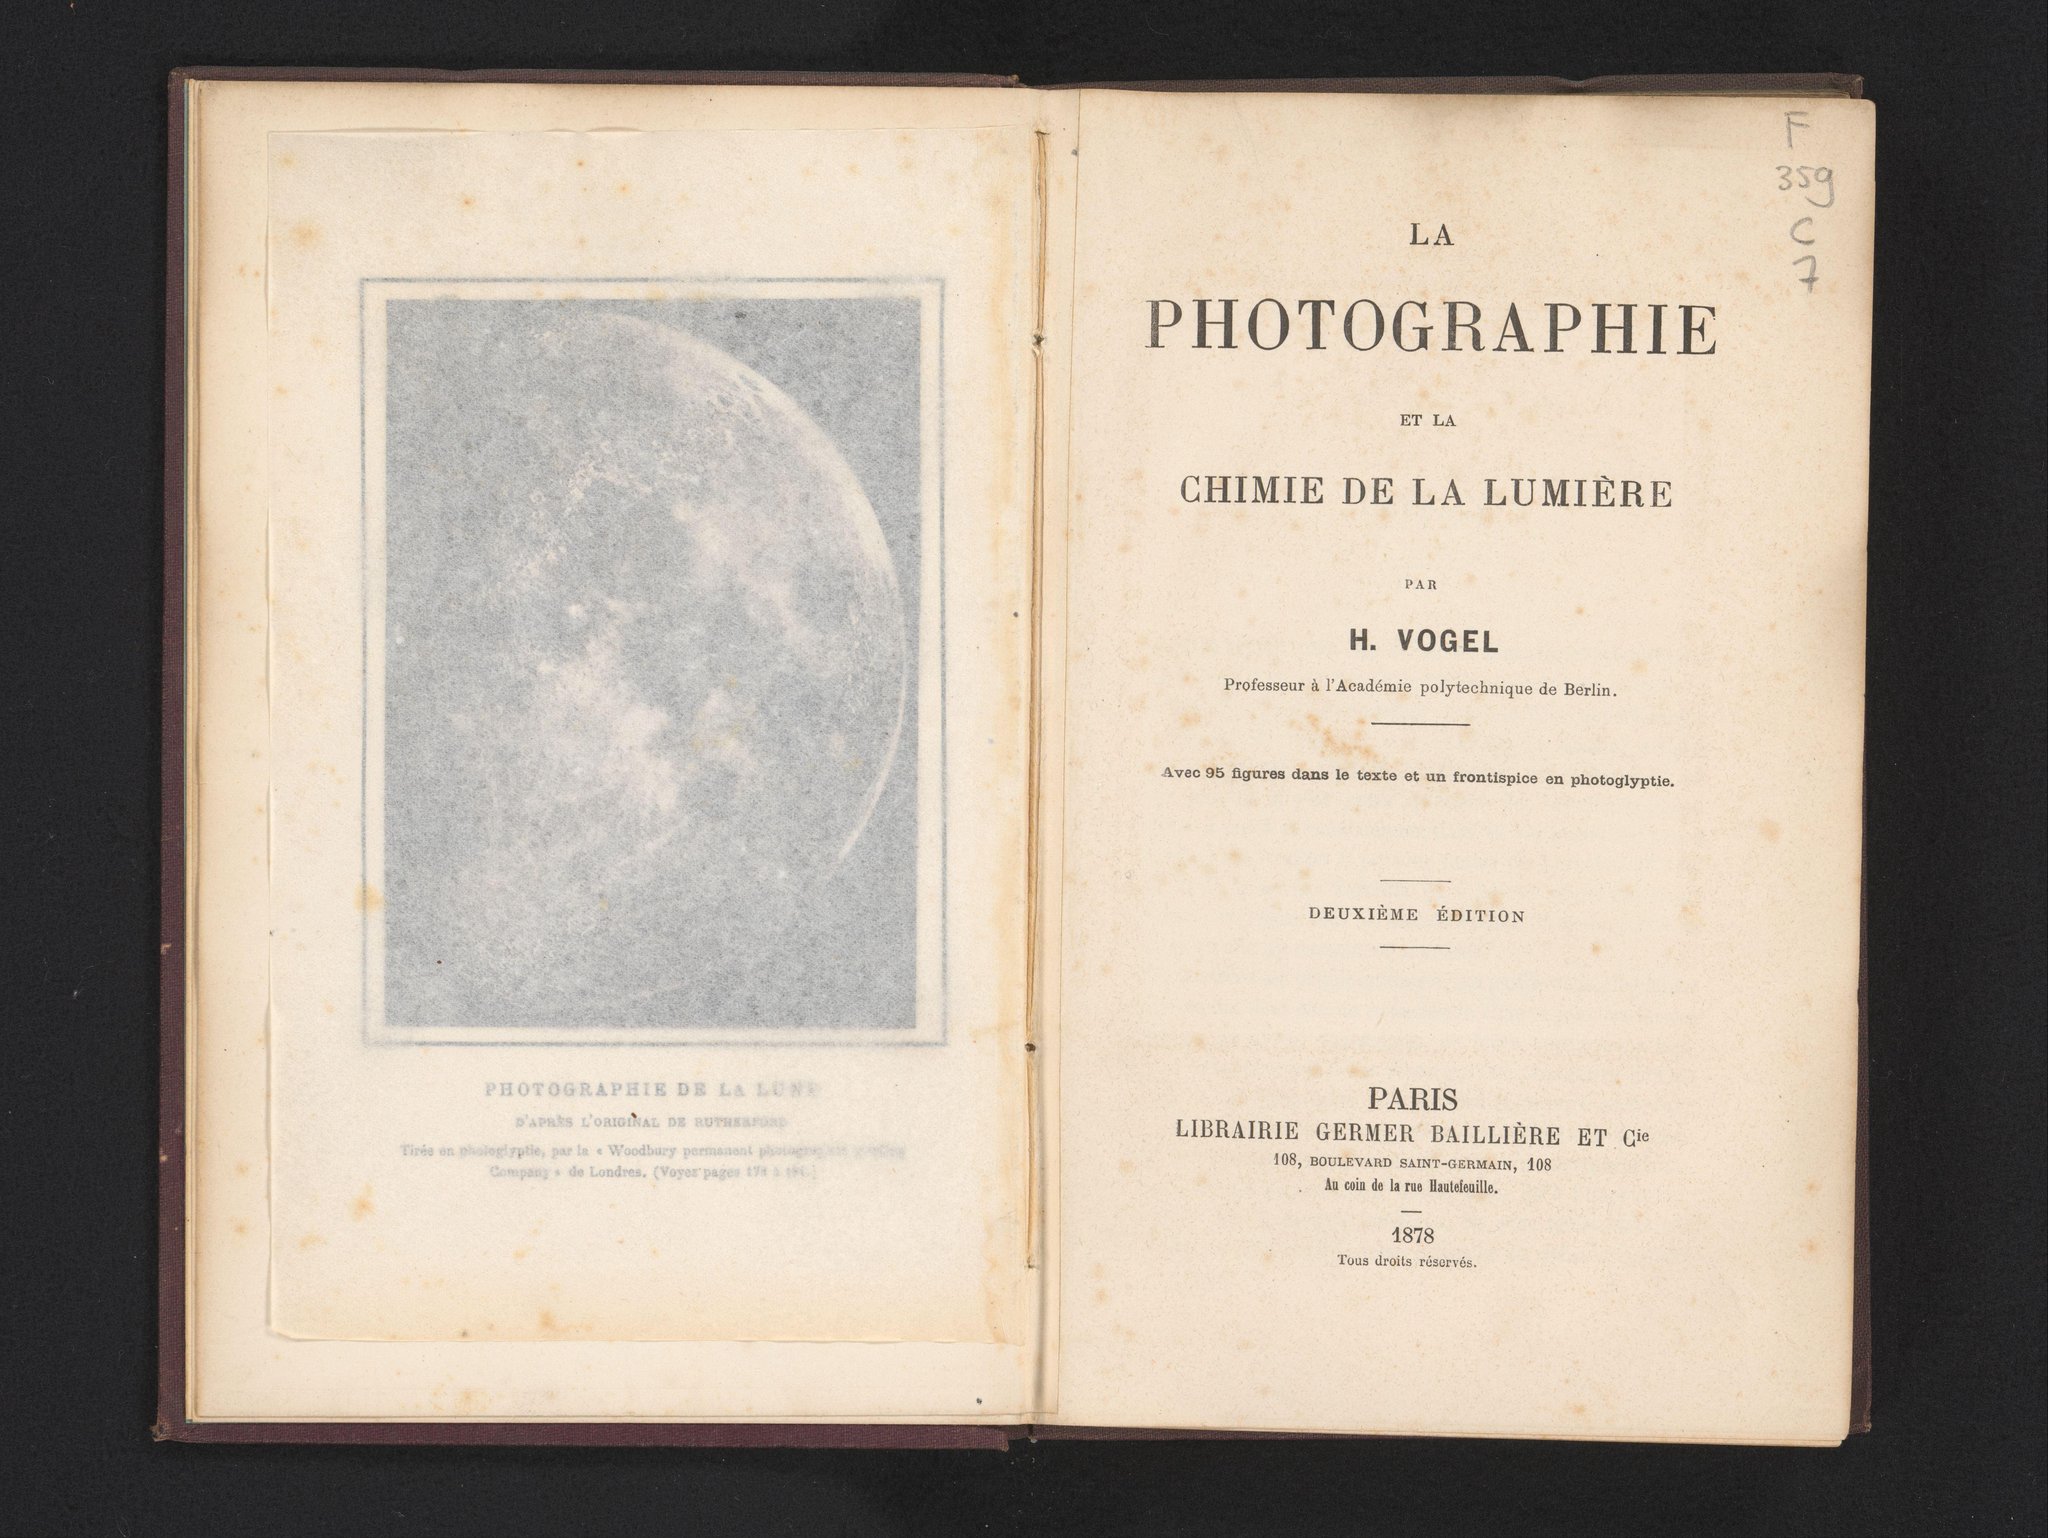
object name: book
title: La photographie et la chimie de la lumière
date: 1878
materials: cardboard, paper, textile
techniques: printing, woodburytype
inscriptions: bookplate: ‘Ex SFJ Libirs’, annotation: ‘JUL 1992’